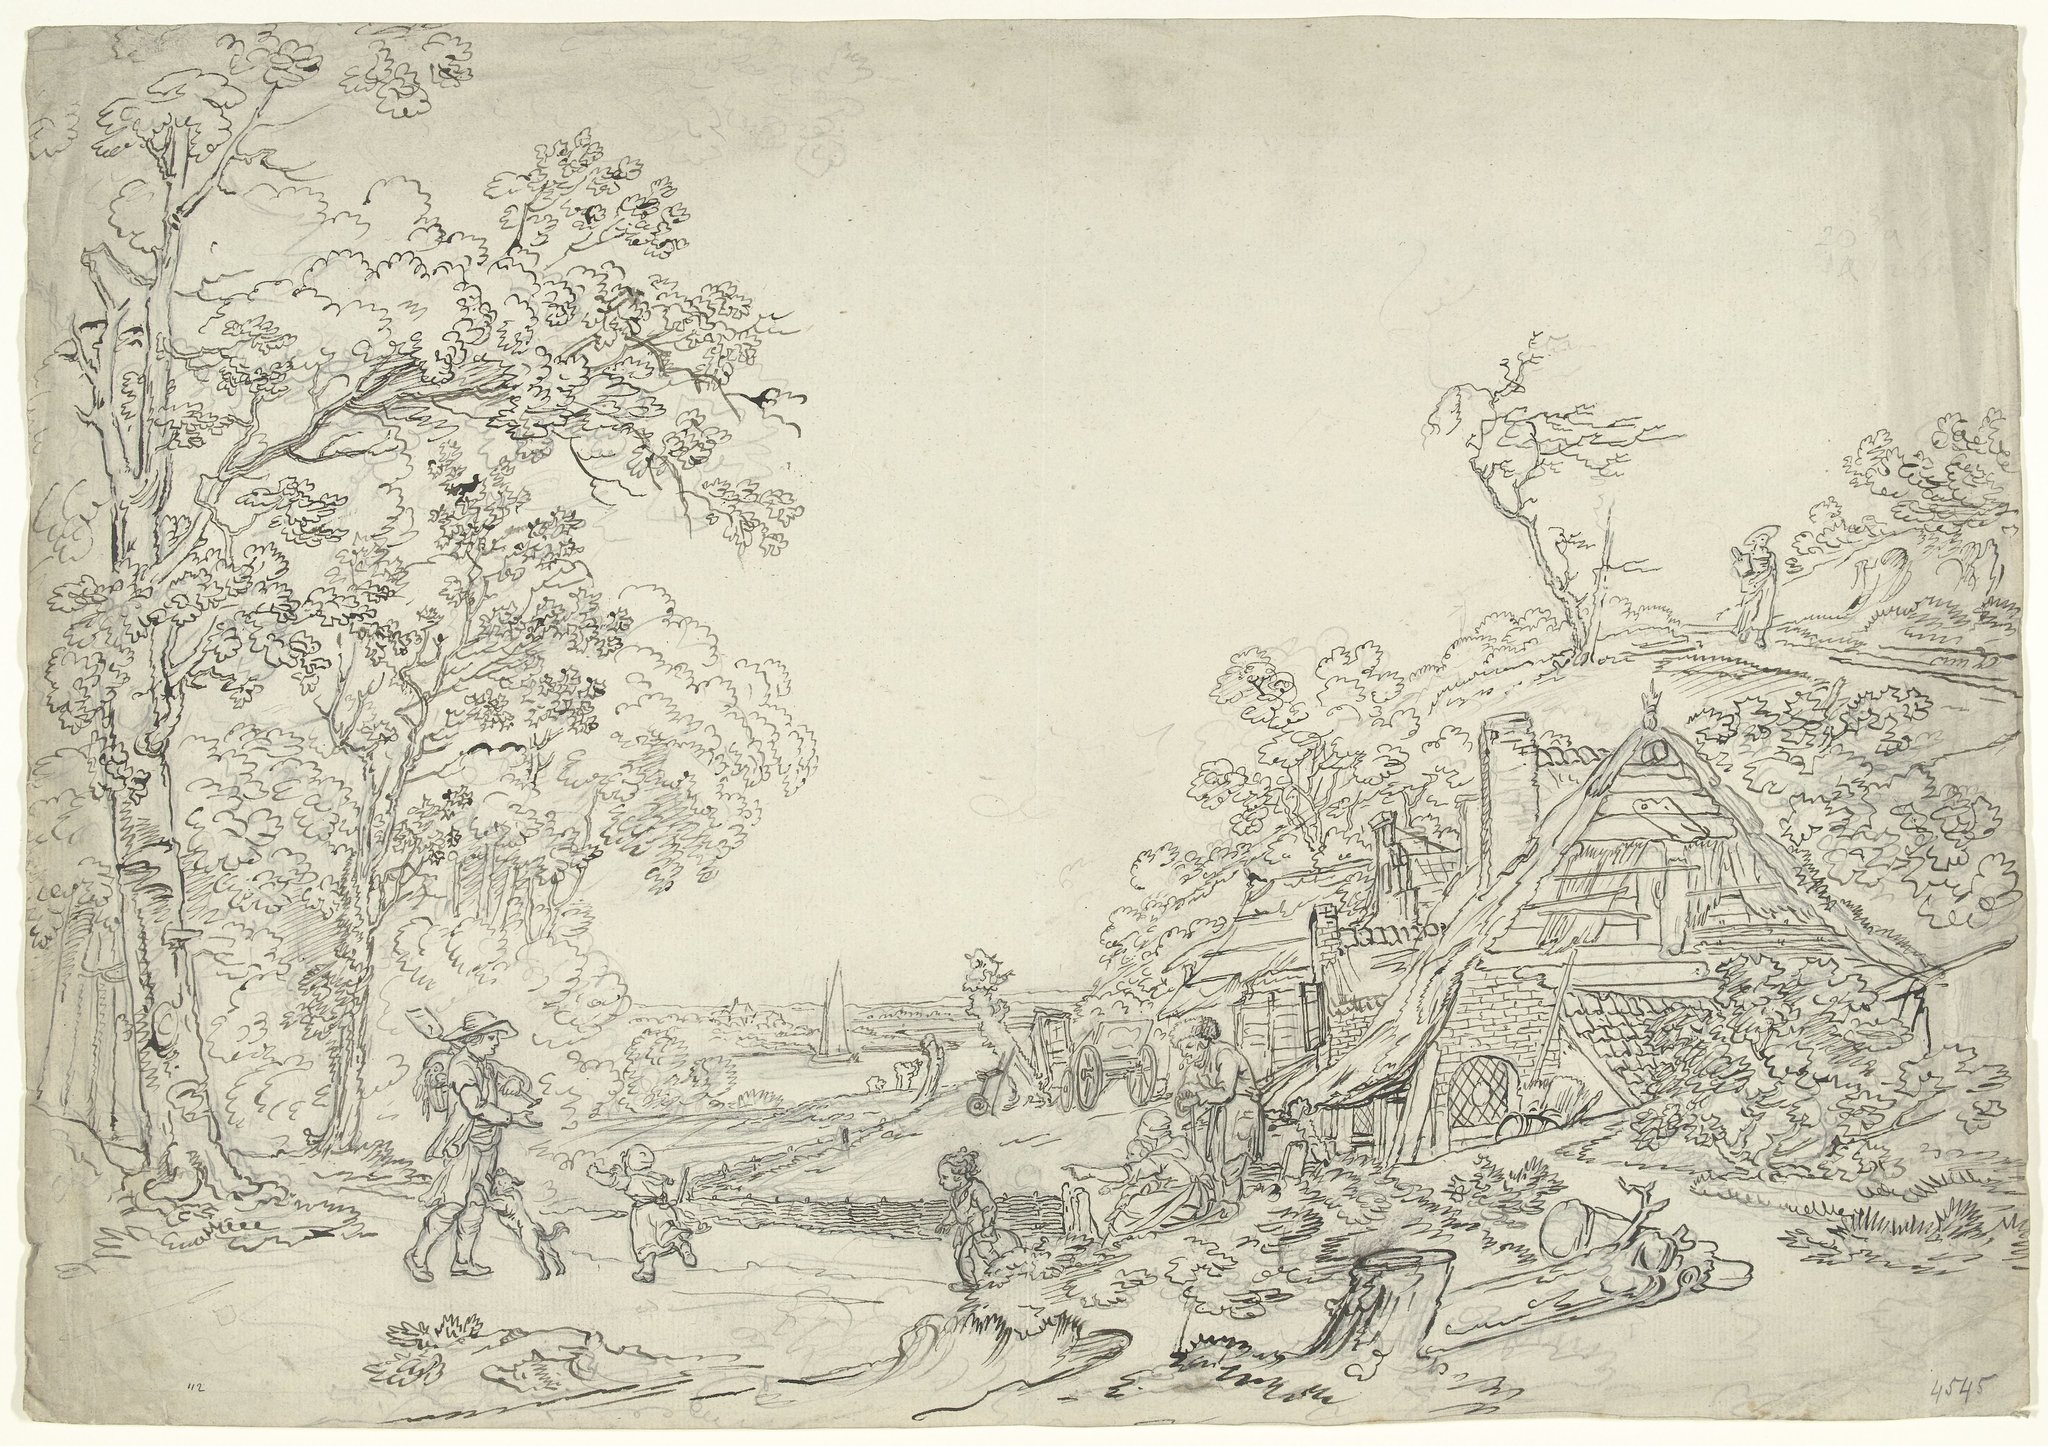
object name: drawing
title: Landschap met gezin voor boerderij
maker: Anonymous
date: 1700-1800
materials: ink, paper, pencil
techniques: pen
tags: family life